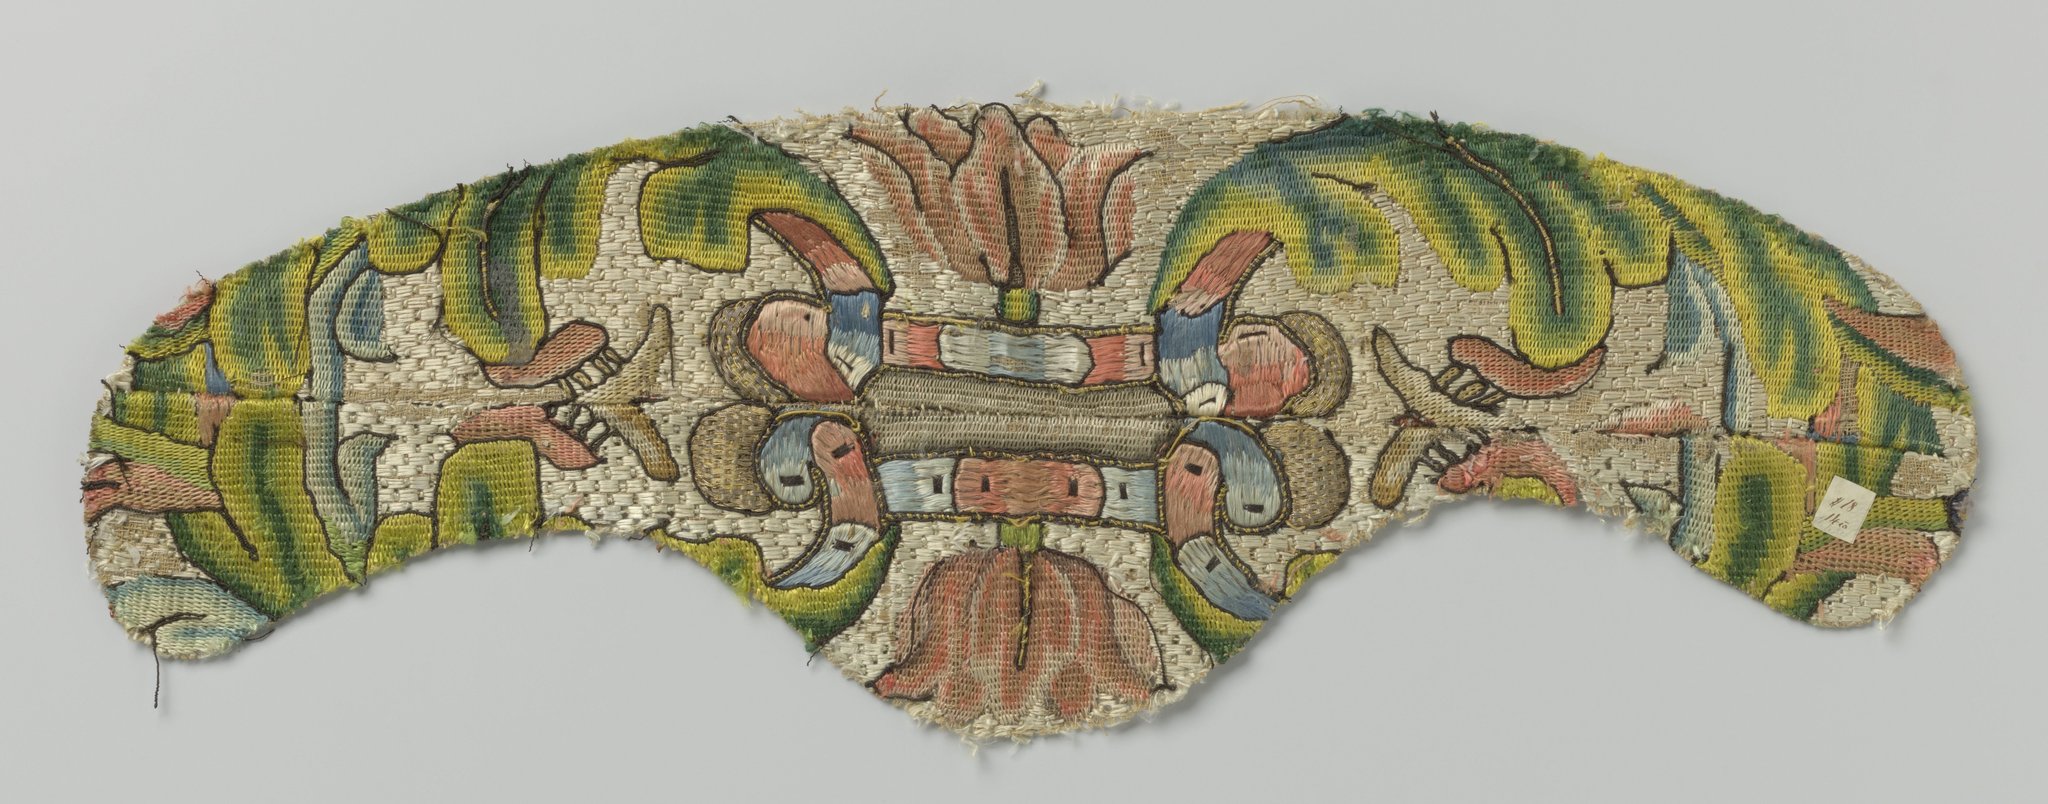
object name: fragment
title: Fragment linnen met veelkleurig borduurwerk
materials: linen, silk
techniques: embroidered, weave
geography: netherlands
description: Fragment wit linnen met veelkleurig borduurwerk. Het patroon heeft bloemen (tulp) en acanthusbladeren. Het fragment bestaat uit twee aaneengenaaide fragmenten.